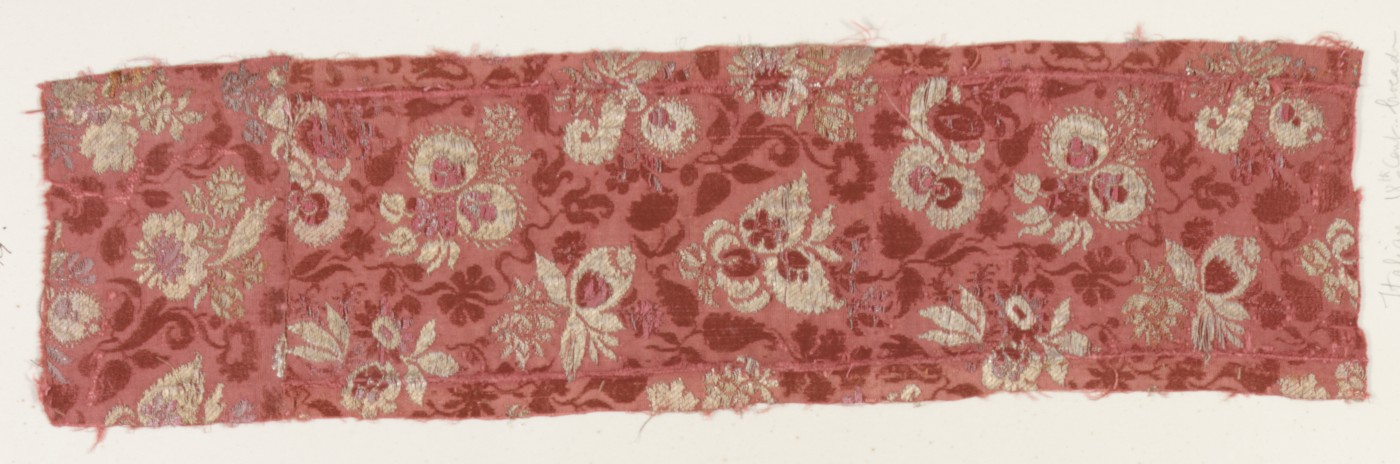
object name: fragment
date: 1701-1800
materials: metal thread, silk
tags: flowers